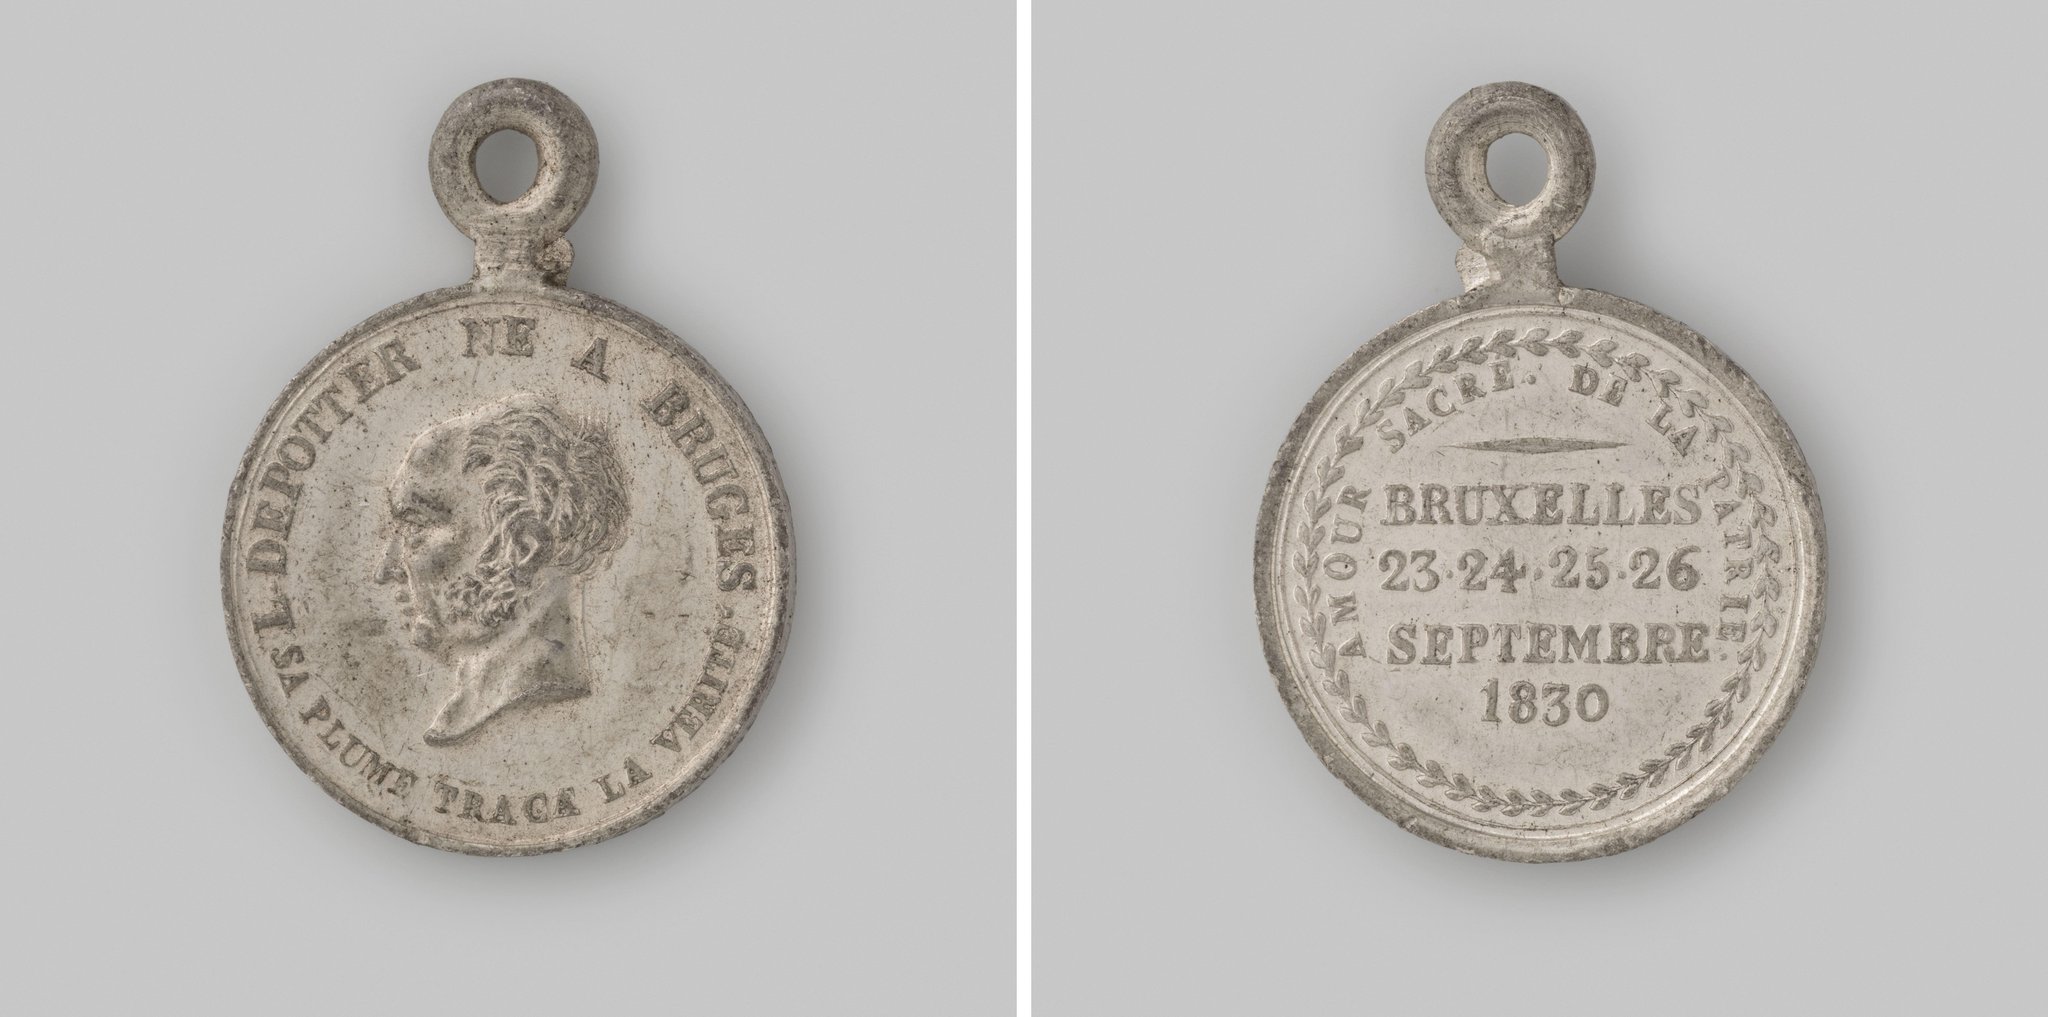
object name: history medal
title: Louis de Potter (1830)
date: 1830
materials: tin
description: Tinnen penning met draagoog, op de voorzijde het portret van De Potter naar links met omschrift, op de keerzijde vier regels ekst met omschrift binnen een dorlopende lauwerkrans.